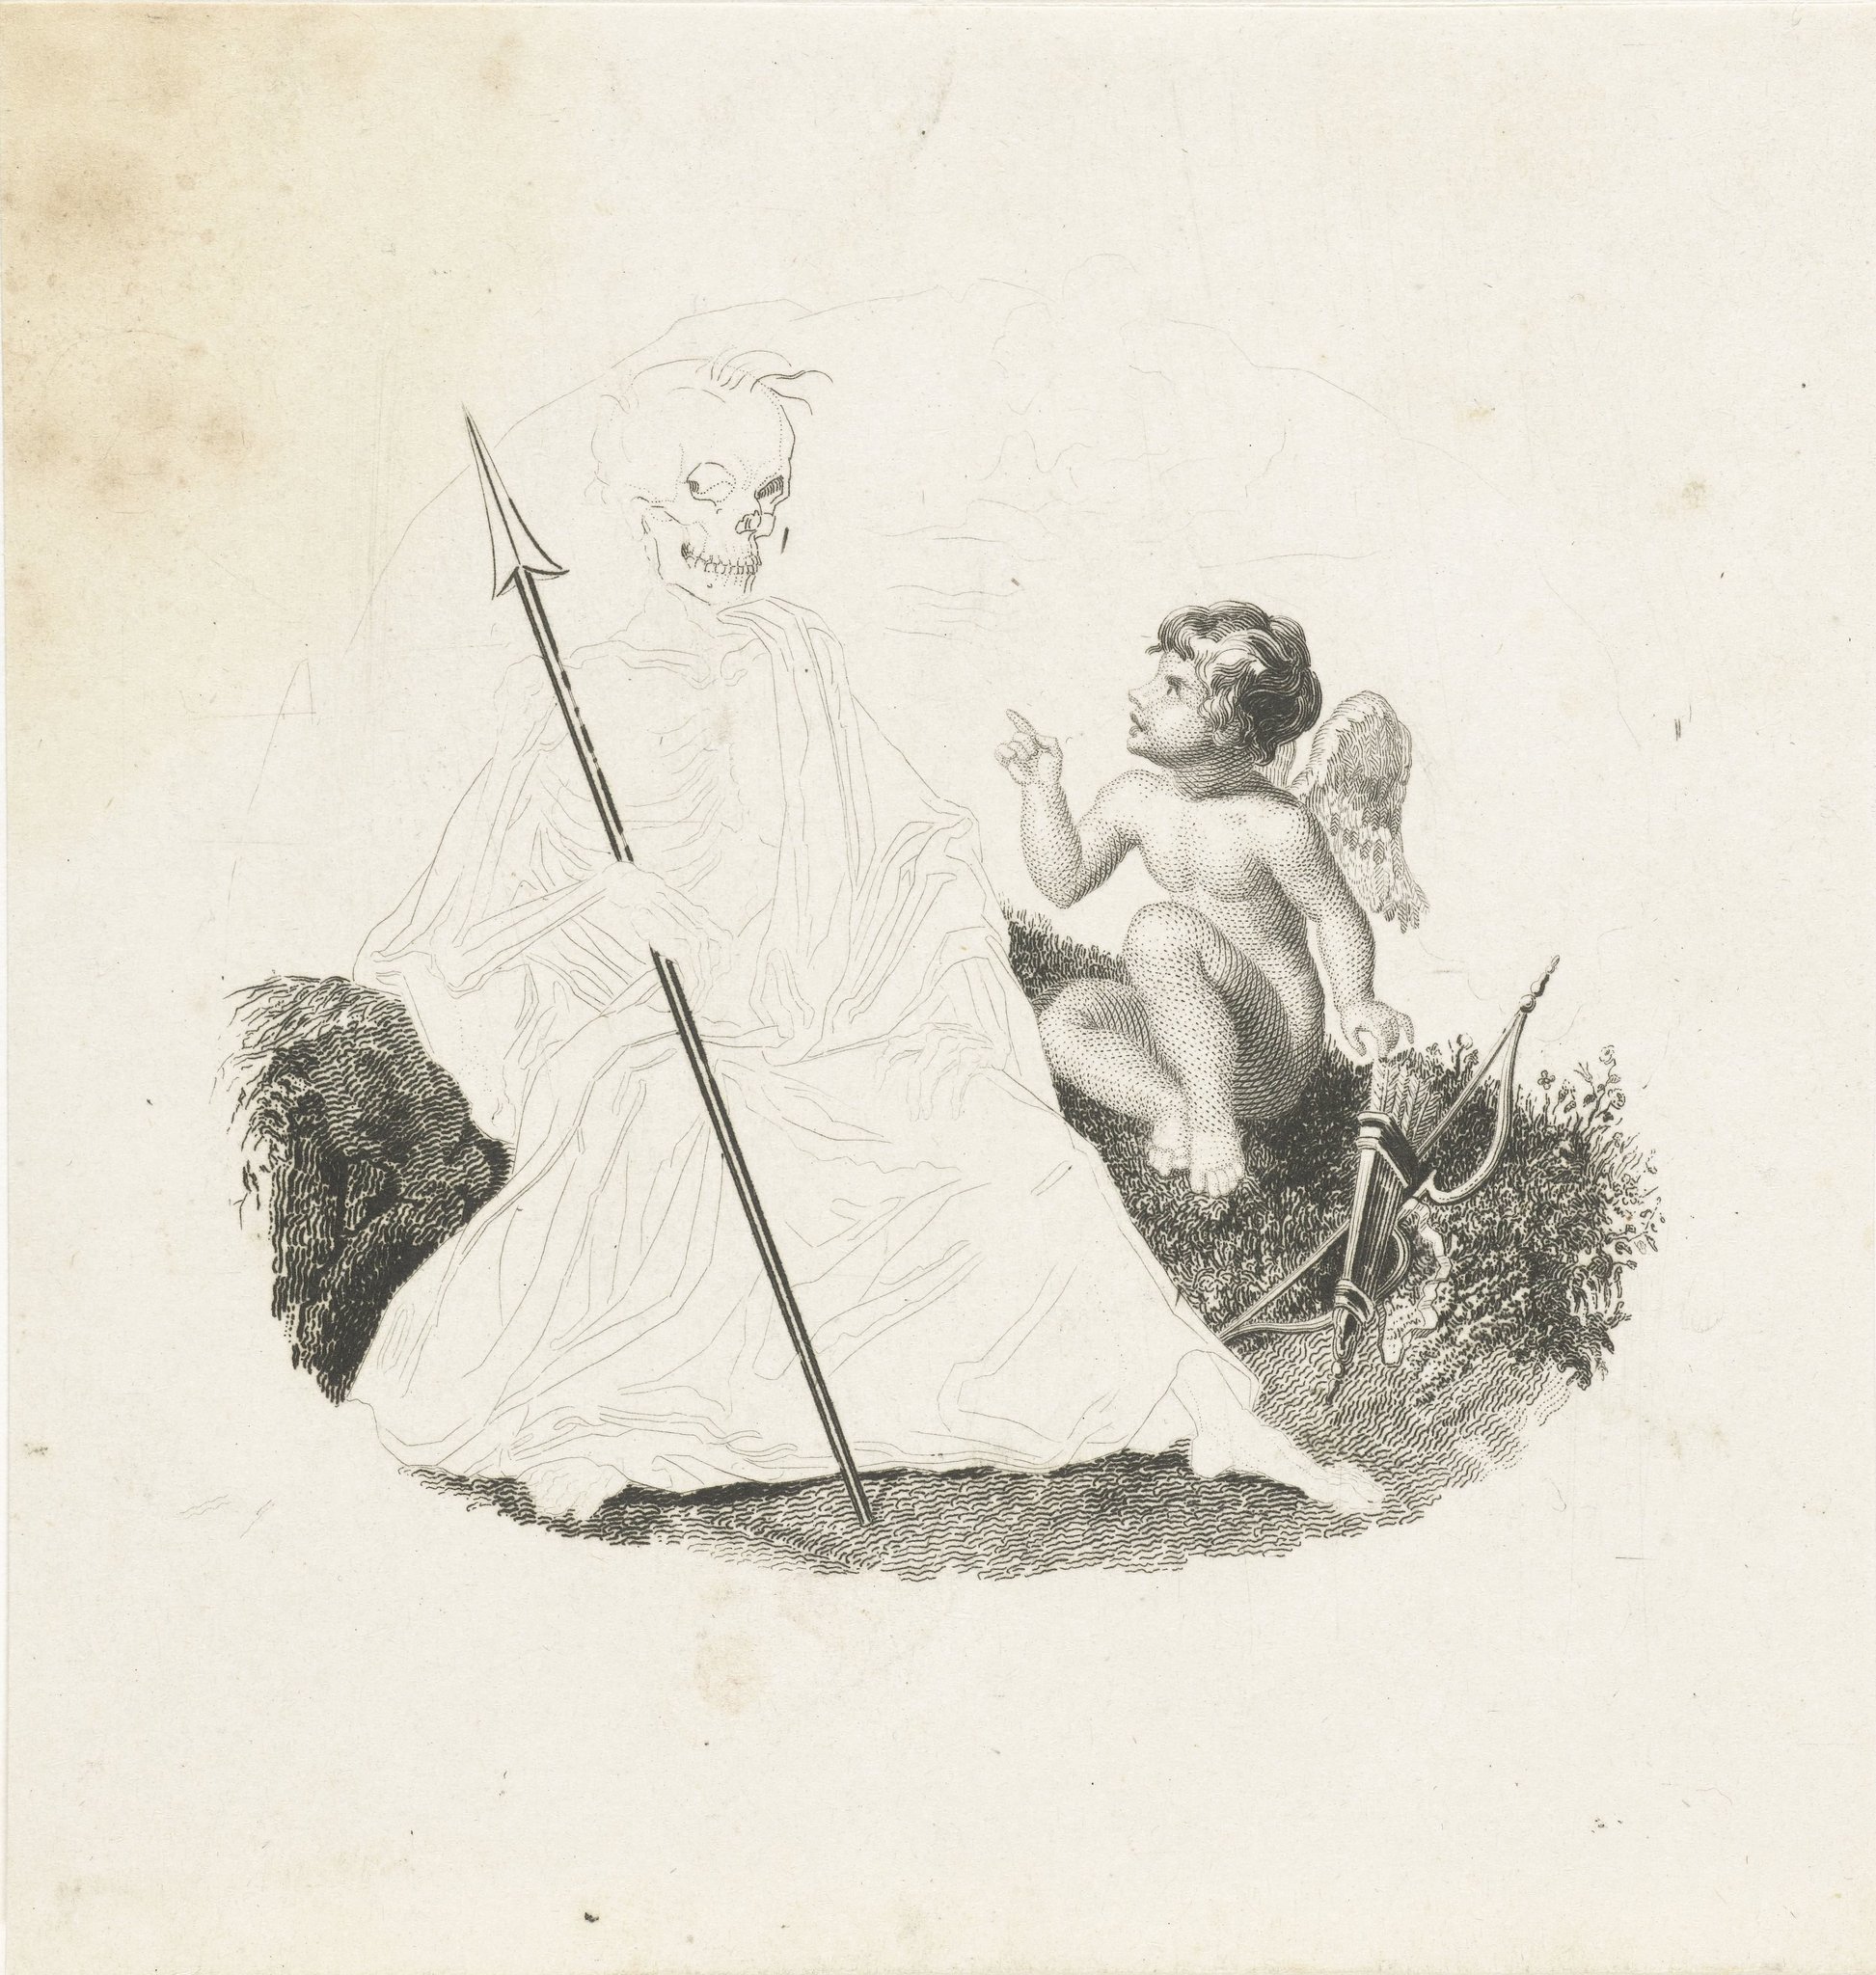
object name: print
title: Amor en de Dood, als geraamte met speer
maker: henricus wilhelmus couwenberg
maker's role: draughtsman, print maker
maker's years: 1814-1845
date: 1830-1845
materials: paper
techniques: etching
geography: amsterdam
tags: death as skeleton, (story of) cupid, amor (eros)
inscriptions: collector's mark: Lugt 2228